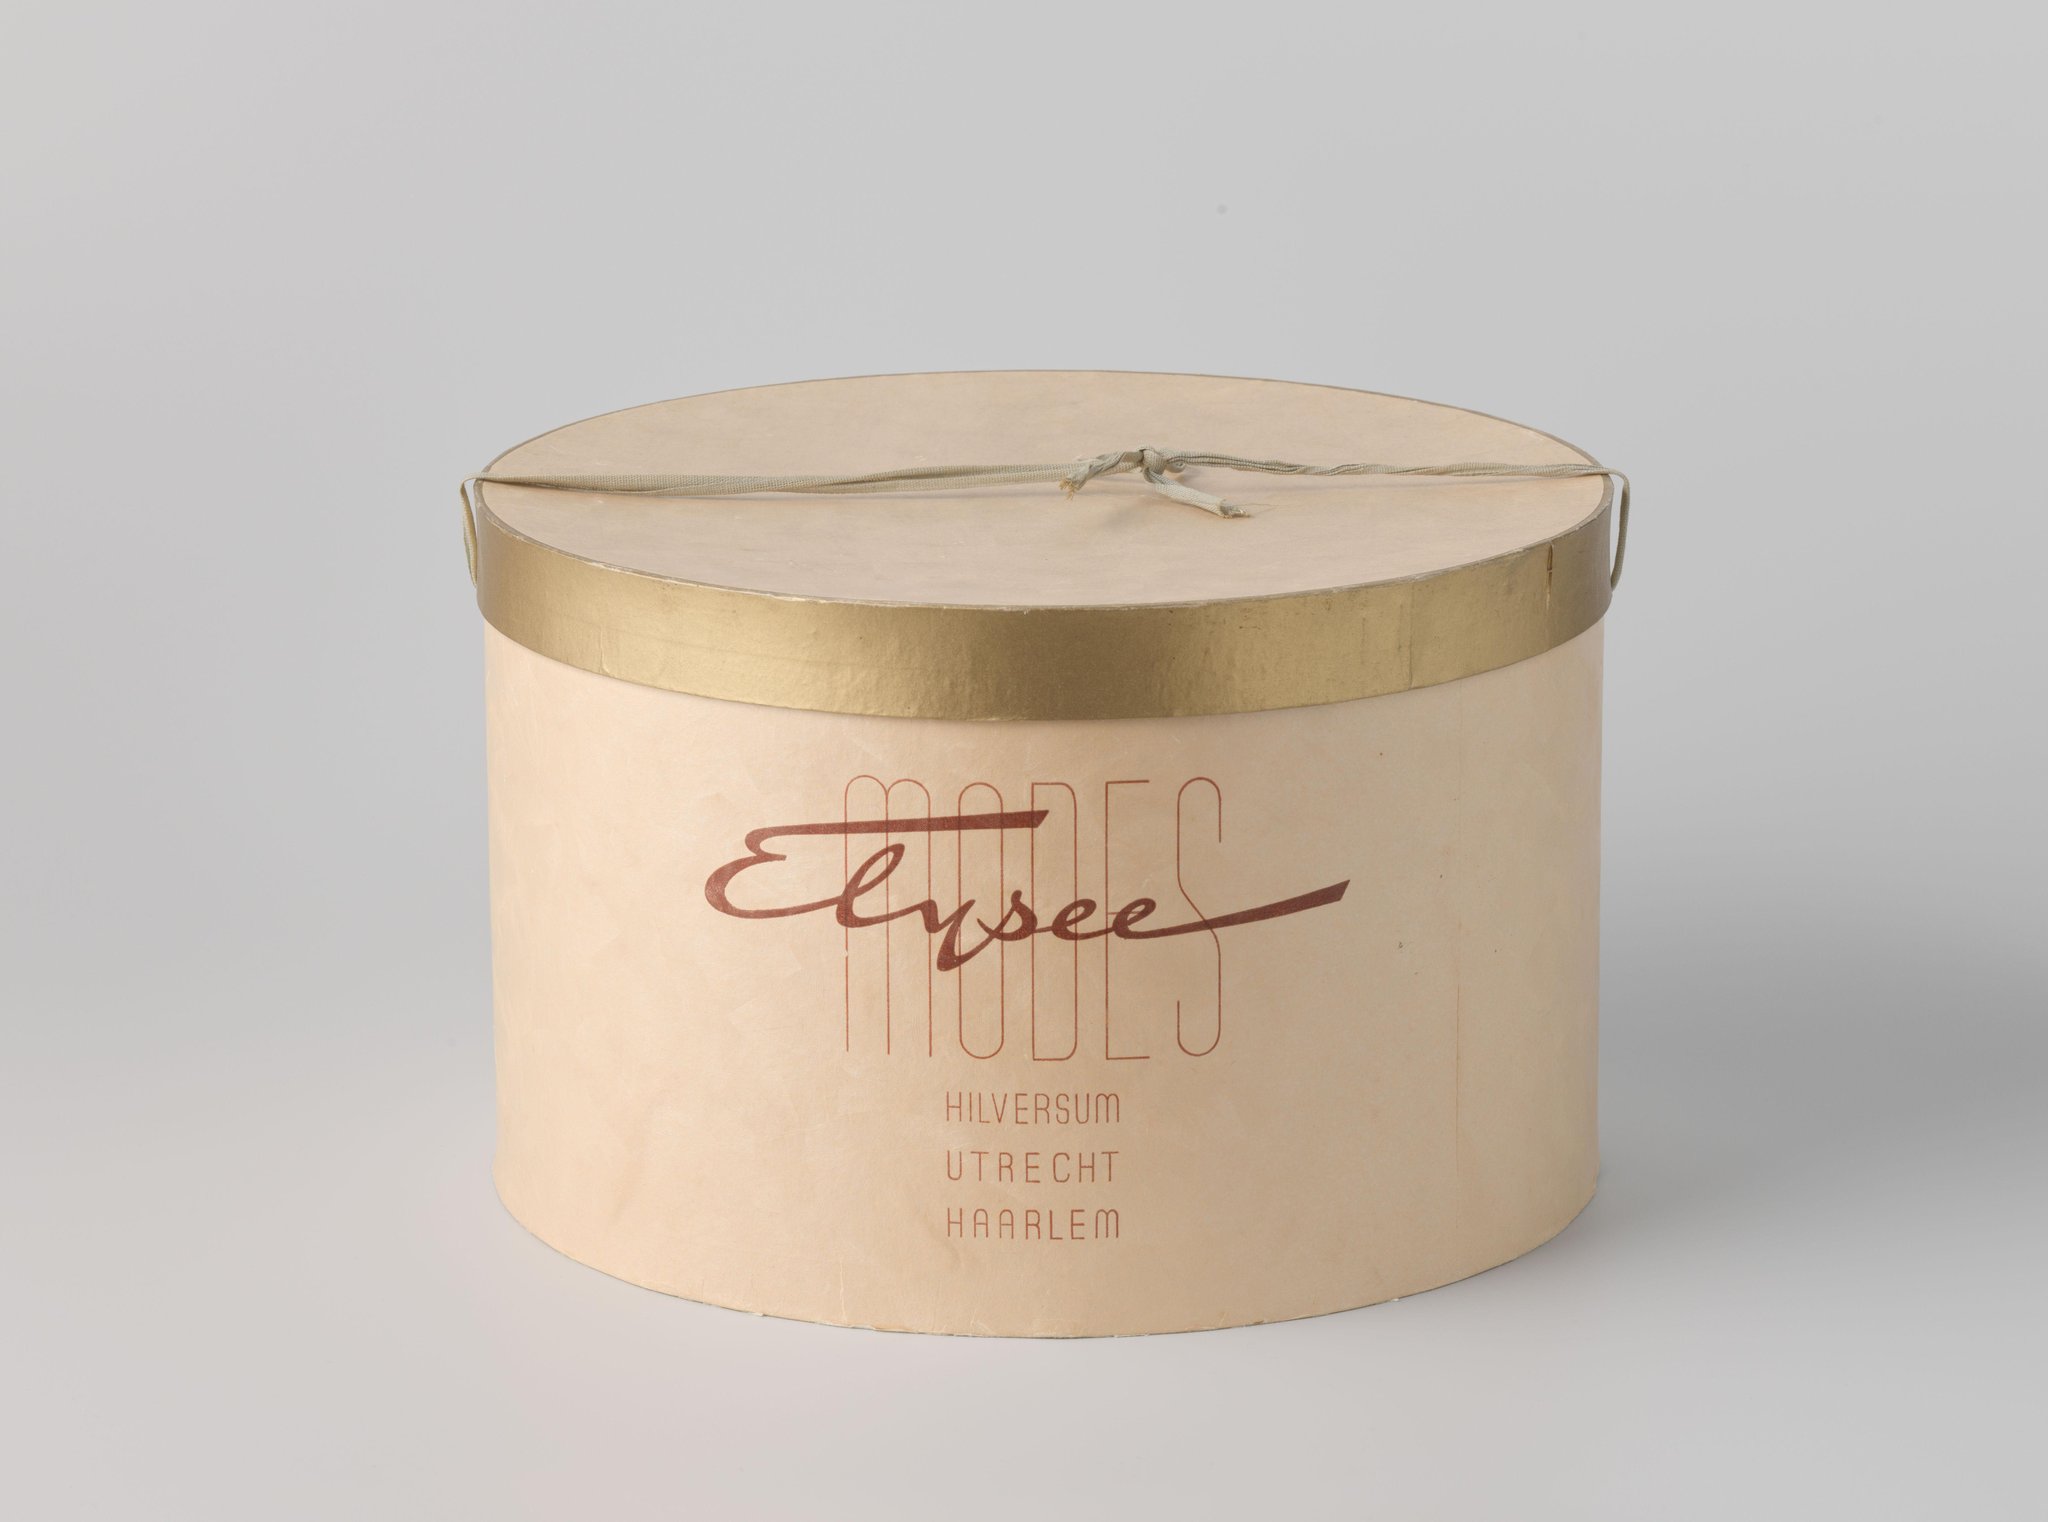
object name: hat box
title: Ronde hoedendoos van karton, beplakt met crèmekleurig papier; met los deksel dat langs de randen is beplakt met steenrood papier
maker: Anonymous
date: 1950-1975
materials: cardboard, paper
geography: western europe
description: Ronde hoedendoos van karton, beplakt met crèmekleurig papier. Het losse deksel is langs de randen beplakt met steenrood papier. Met draaglinten.